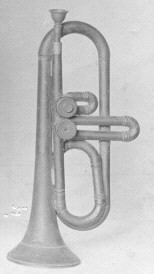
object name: soprano saxhorn in b flat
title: Soprano Saxhorn in B-flat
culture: german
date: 1865-1889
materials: metal, wood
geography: germany